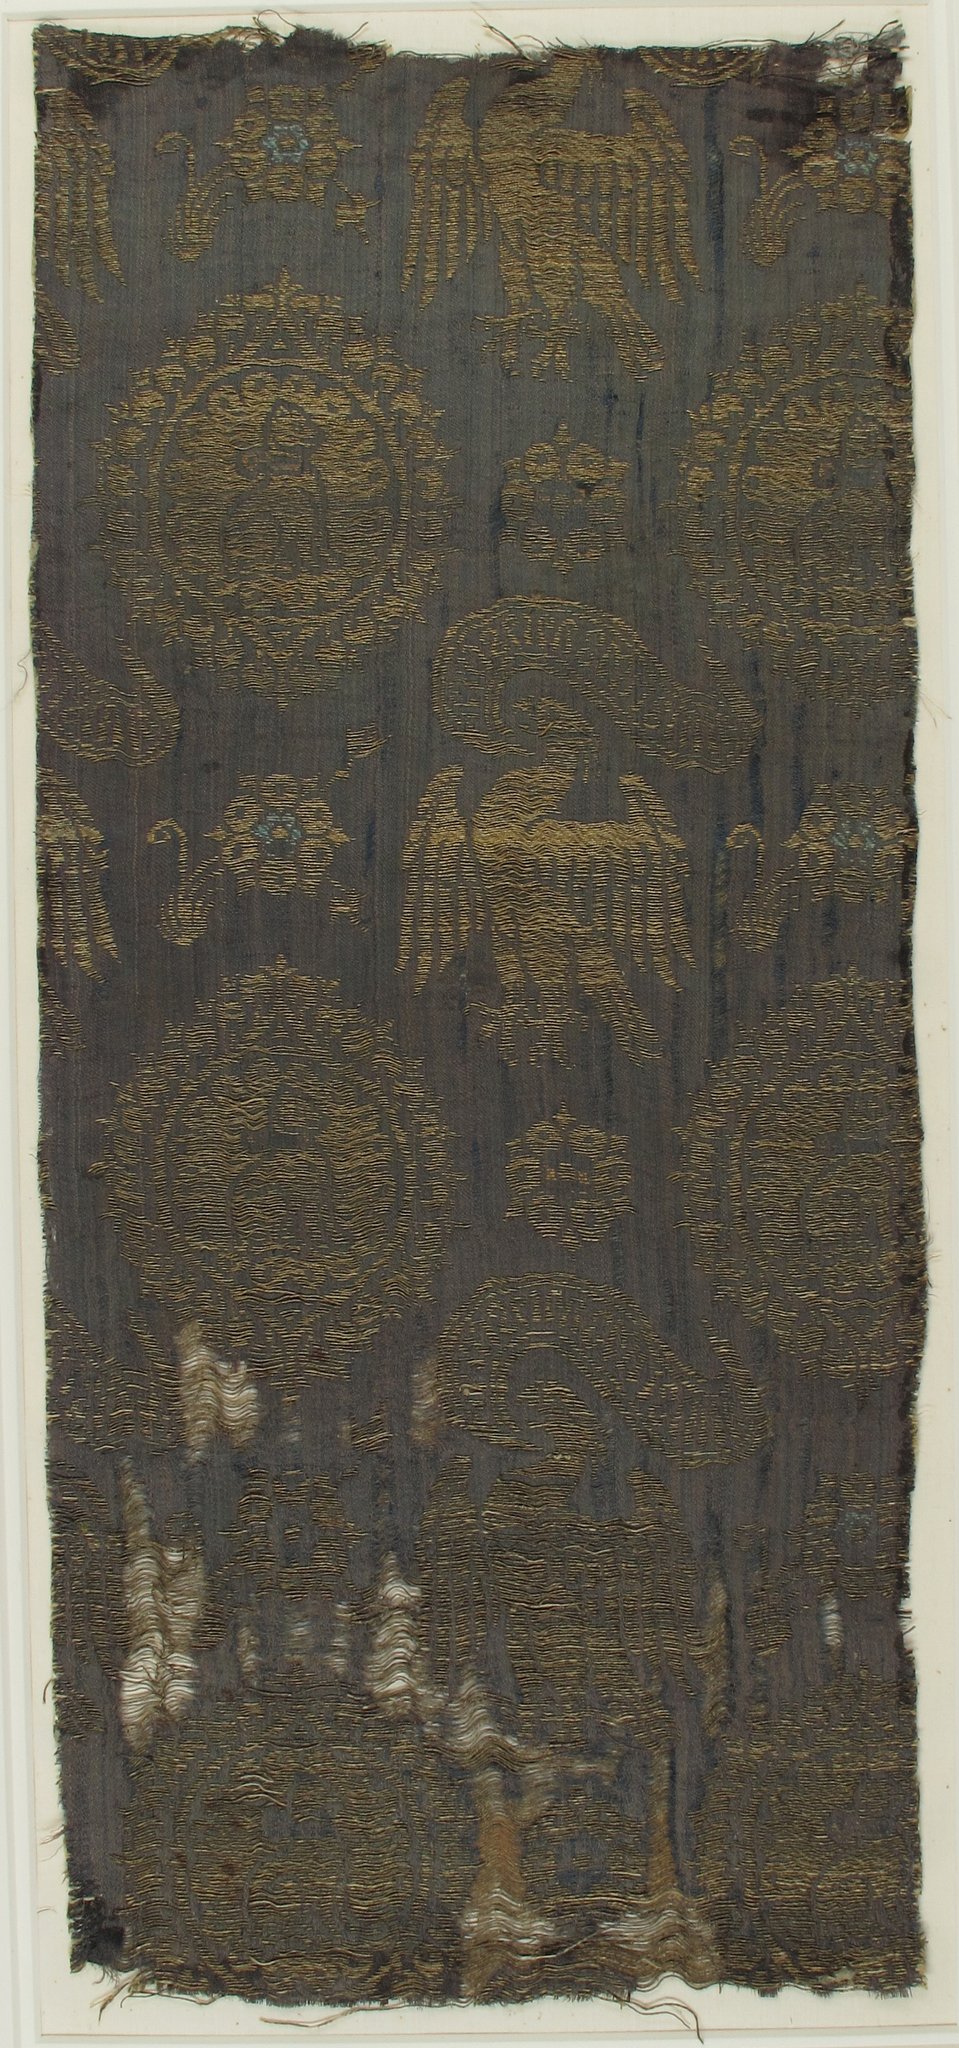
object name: textile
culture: italian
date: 1301-1400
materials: metal thread, silk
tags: eagles